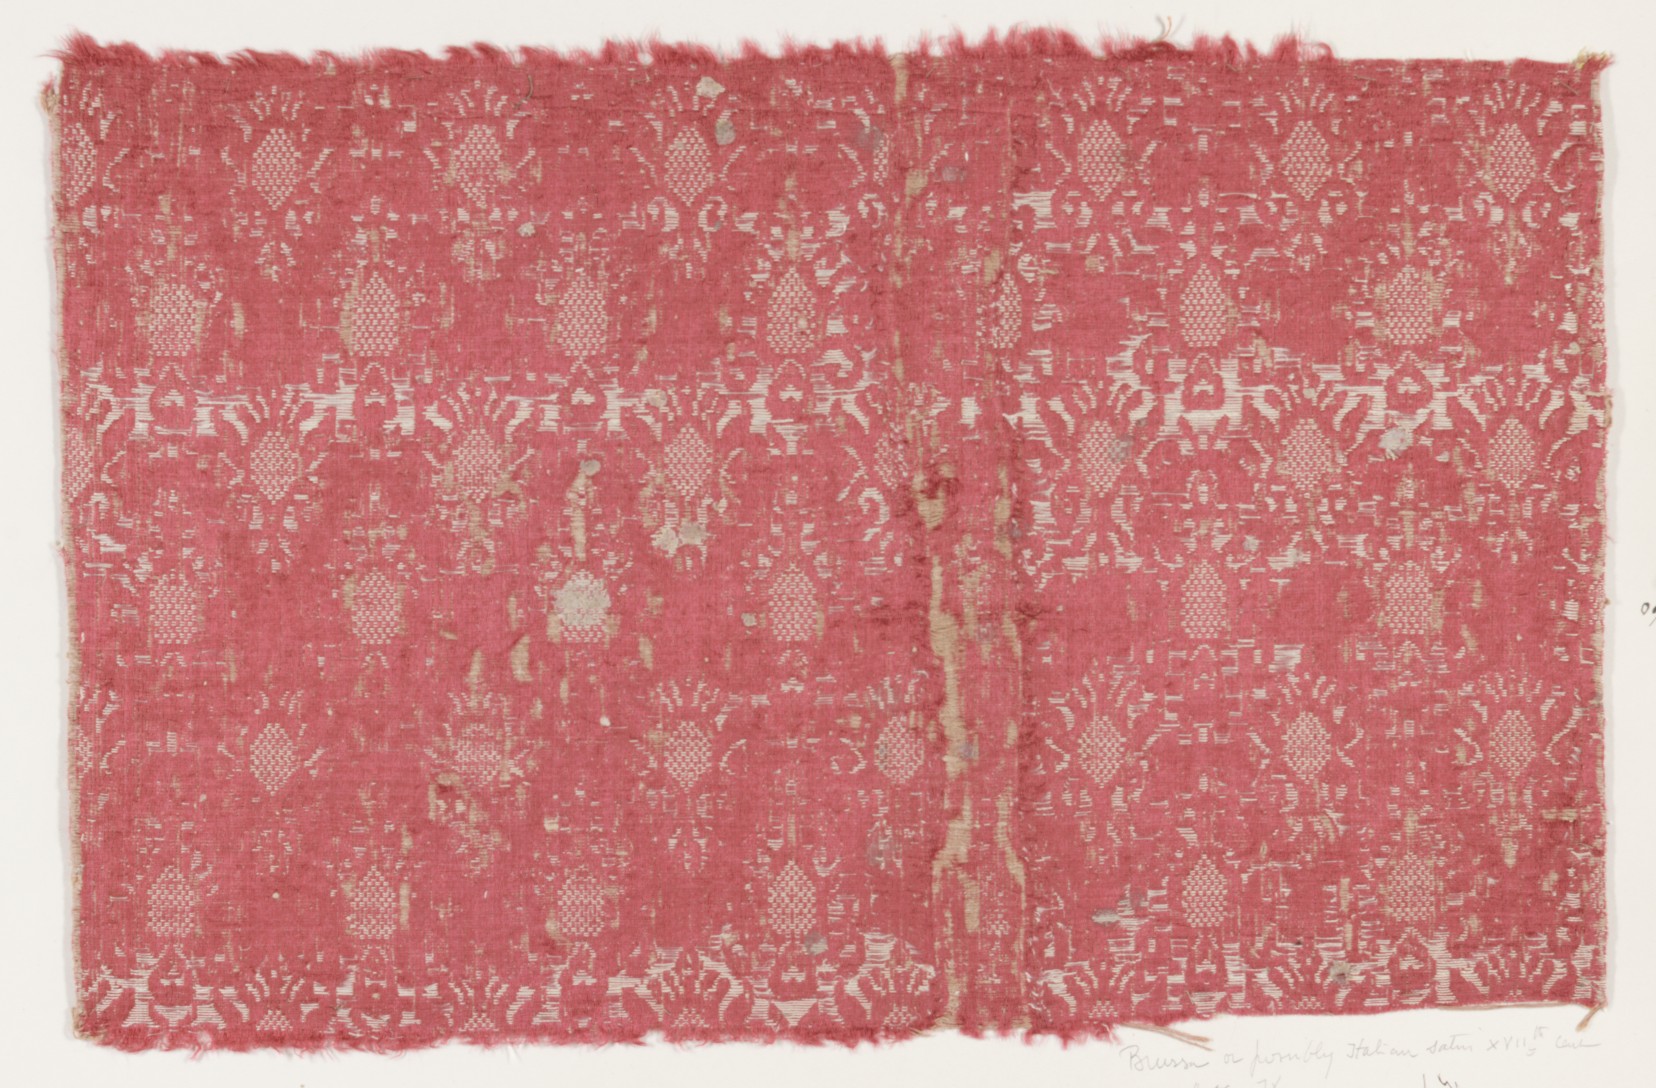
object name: fragment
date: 1601-1700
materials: silk